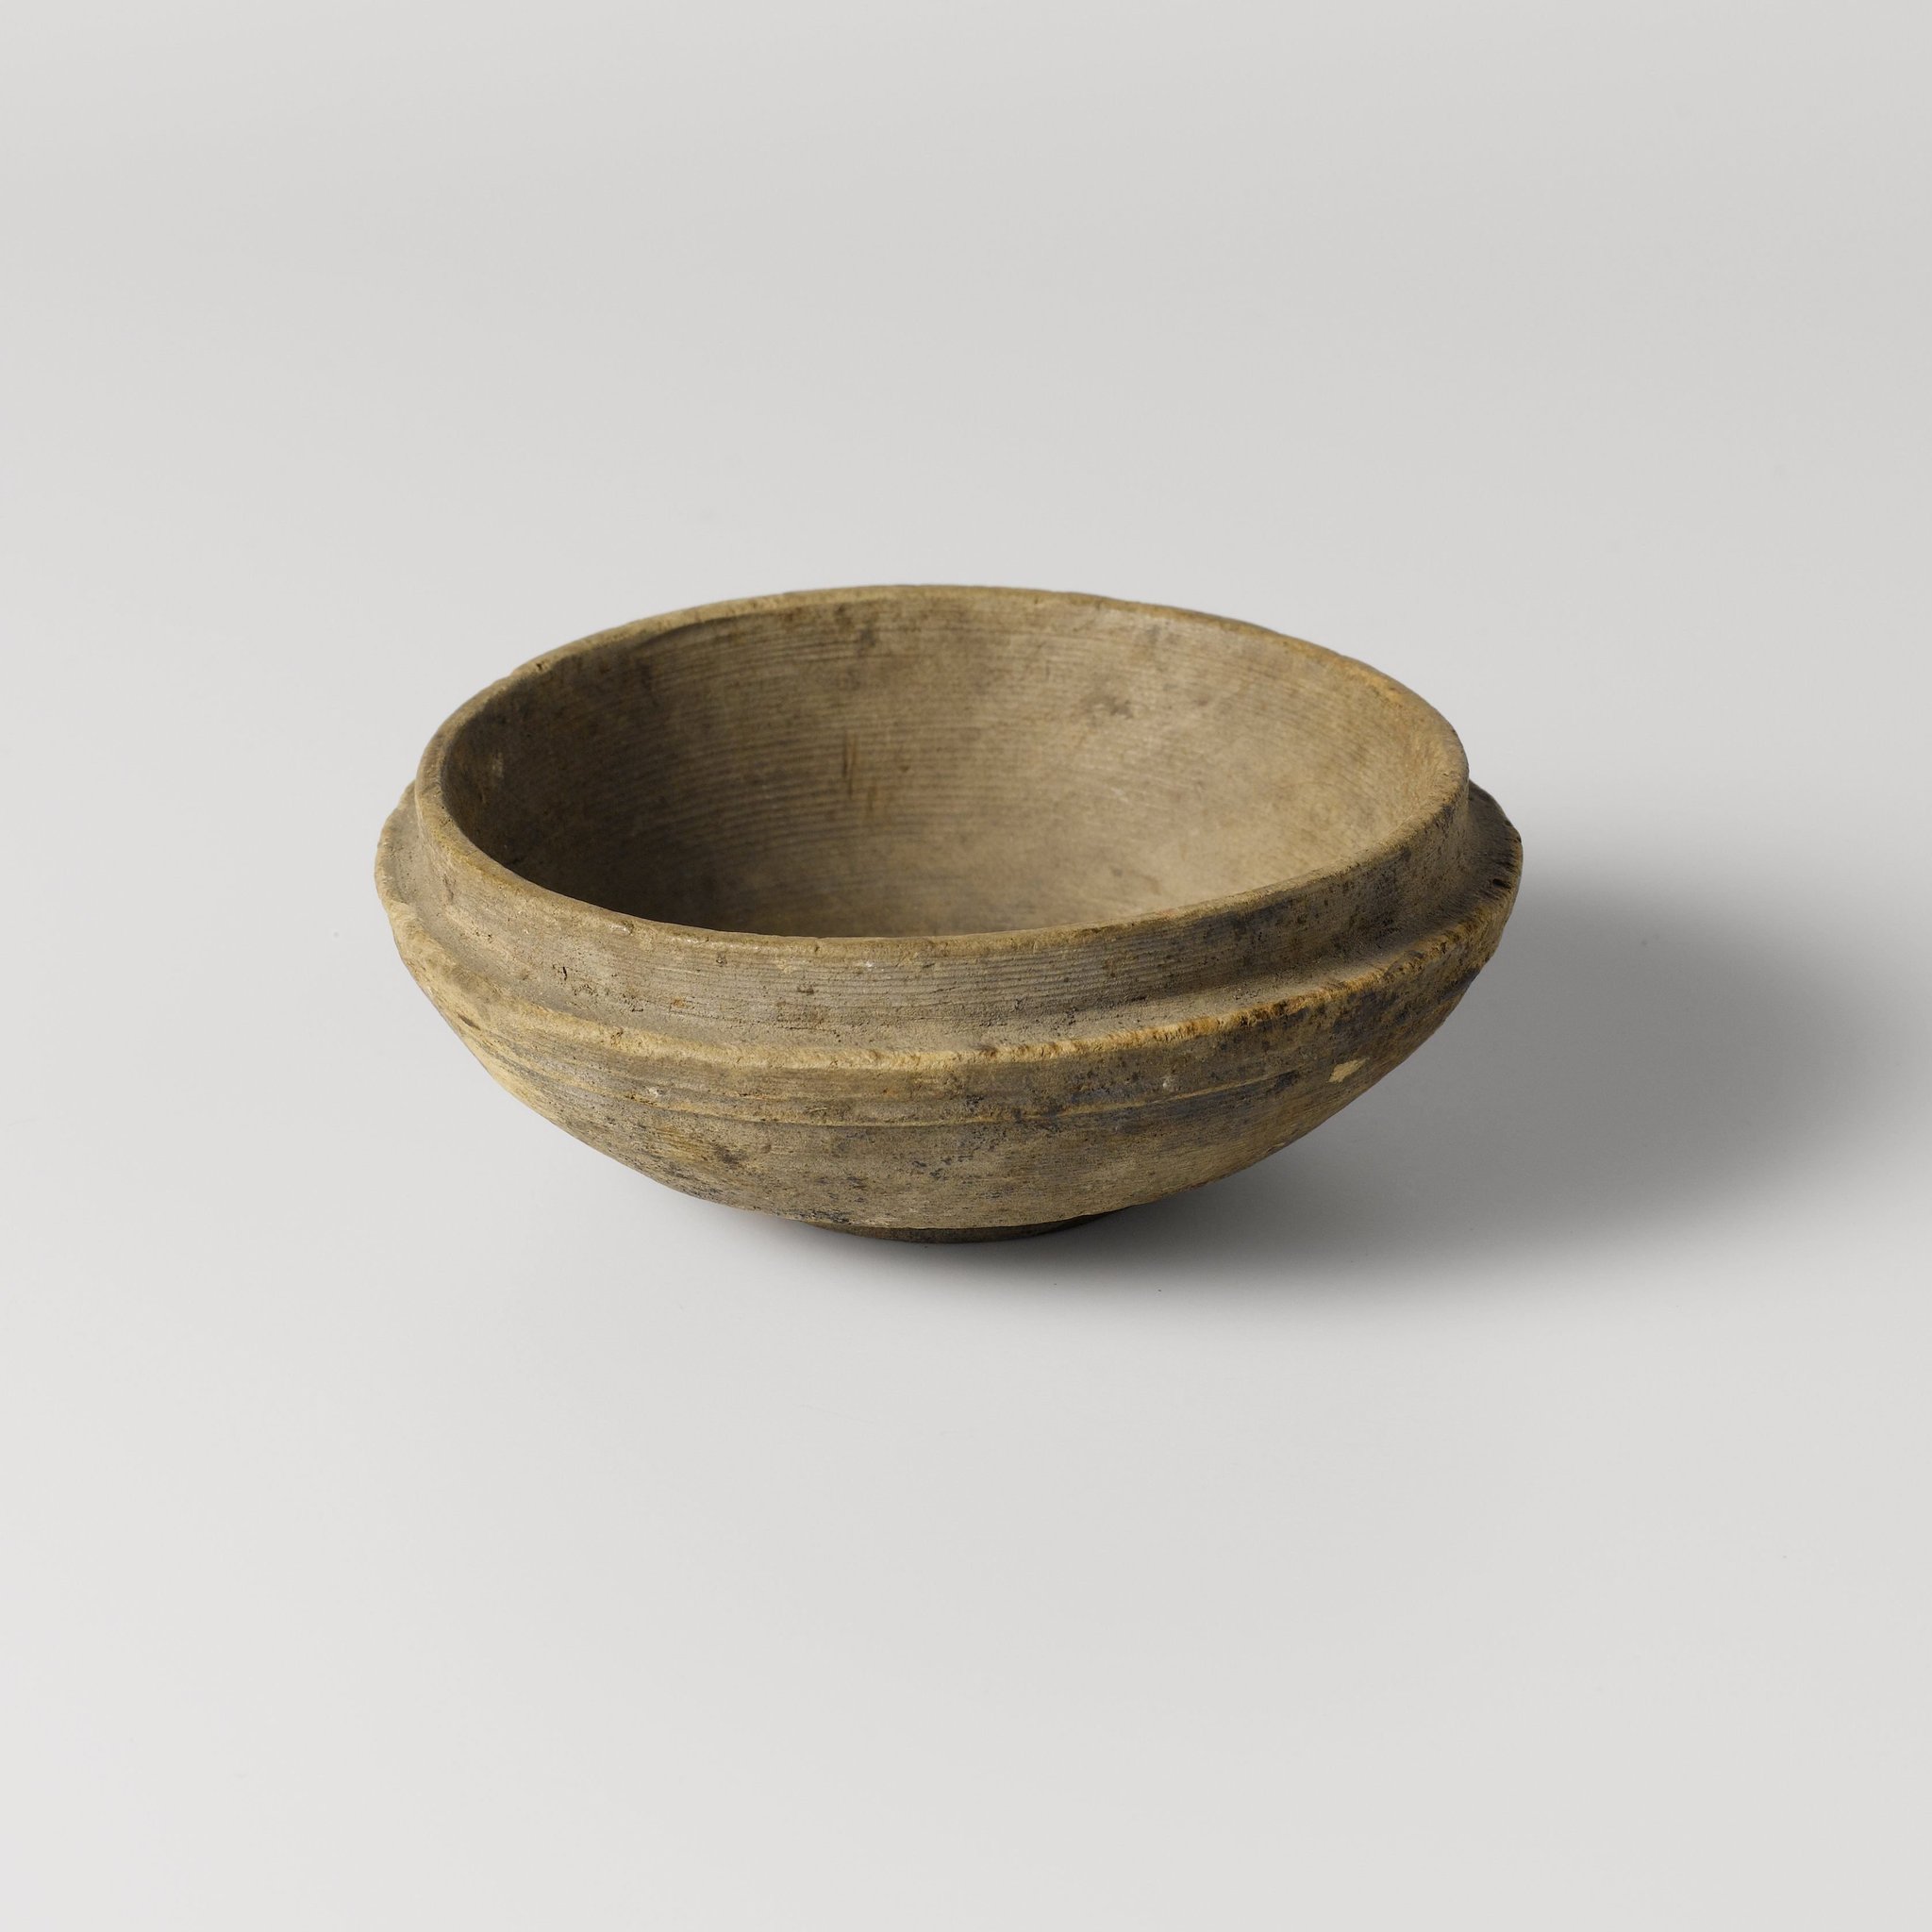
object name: lid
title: Deksel van nap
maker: Anonymous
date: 1590-1596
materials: wood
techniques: turning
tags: willem barendsz., amsterdam, jacob van heemskerck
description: Deksel waarvan aan de basis een rand uitgespaard is, met bolle buitenwand welke eindigt in een plat vlak. Ter versiering zijn twee randen uitgespaard.